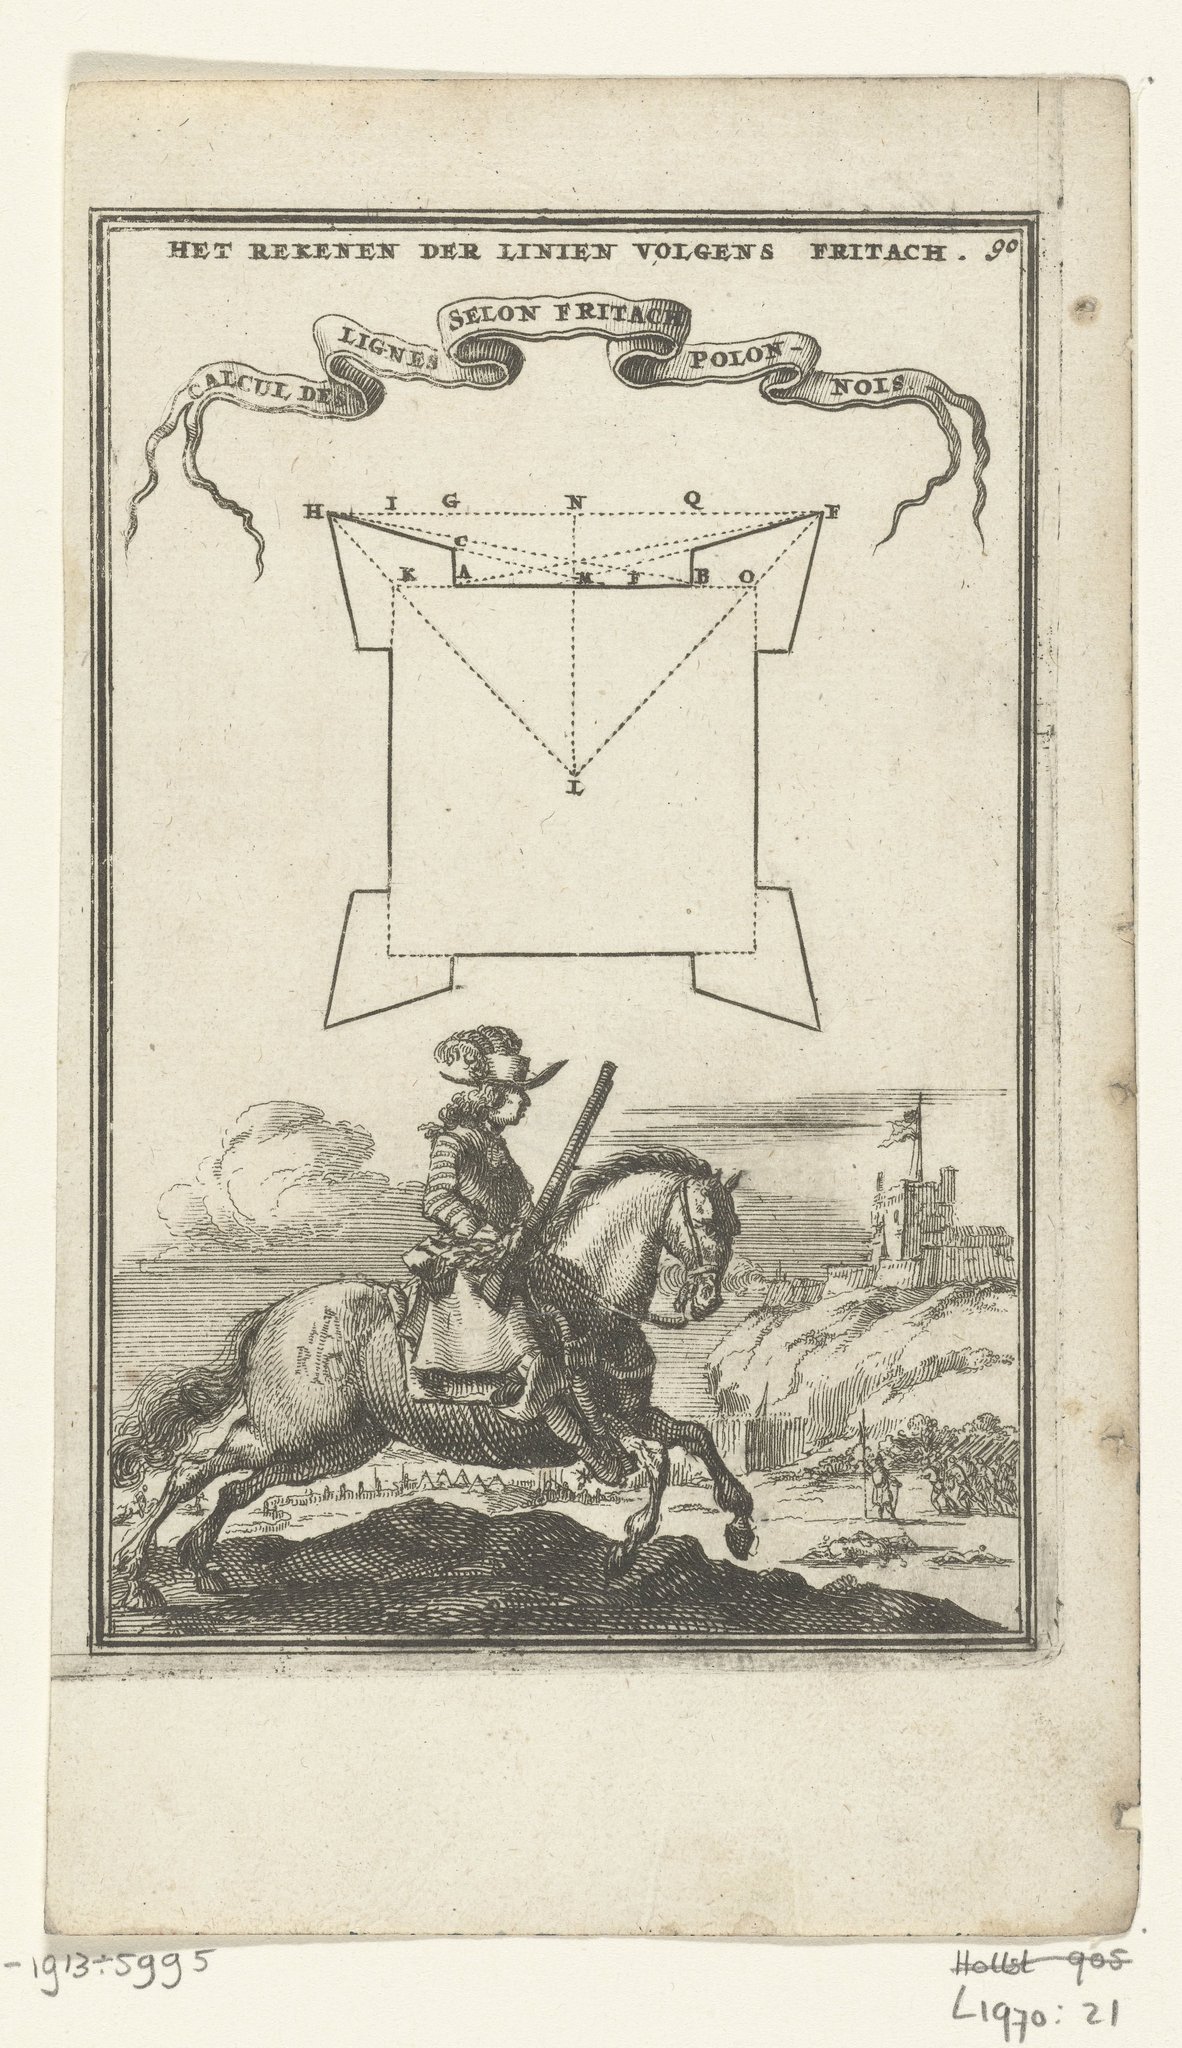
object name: book illustration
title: Illustratie voor 'Den Arbeid van Mars' van Allain Manesson Mallet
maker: romeyn de hooghe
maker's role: draughtsman, goldsmith, painter, print maker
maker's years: 1645-1708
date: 1672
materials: paper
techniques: engraving, etching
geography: amsterdam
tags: warfare; military affairs (+ cavalry, horsemen), fortifications, military engineering, siege, mathematics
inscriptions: collector's mark: Lugt 2228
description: Grondplan voor een vesting, fort of versterking (vierkant). Daaronder een soldaat te paard in de nabijheid van een belegerde vesting. In de hoek rechtsboven het cijfer 90 (= het nummer van de pagina in het boek waartegenover de illustratie geplaatst is).